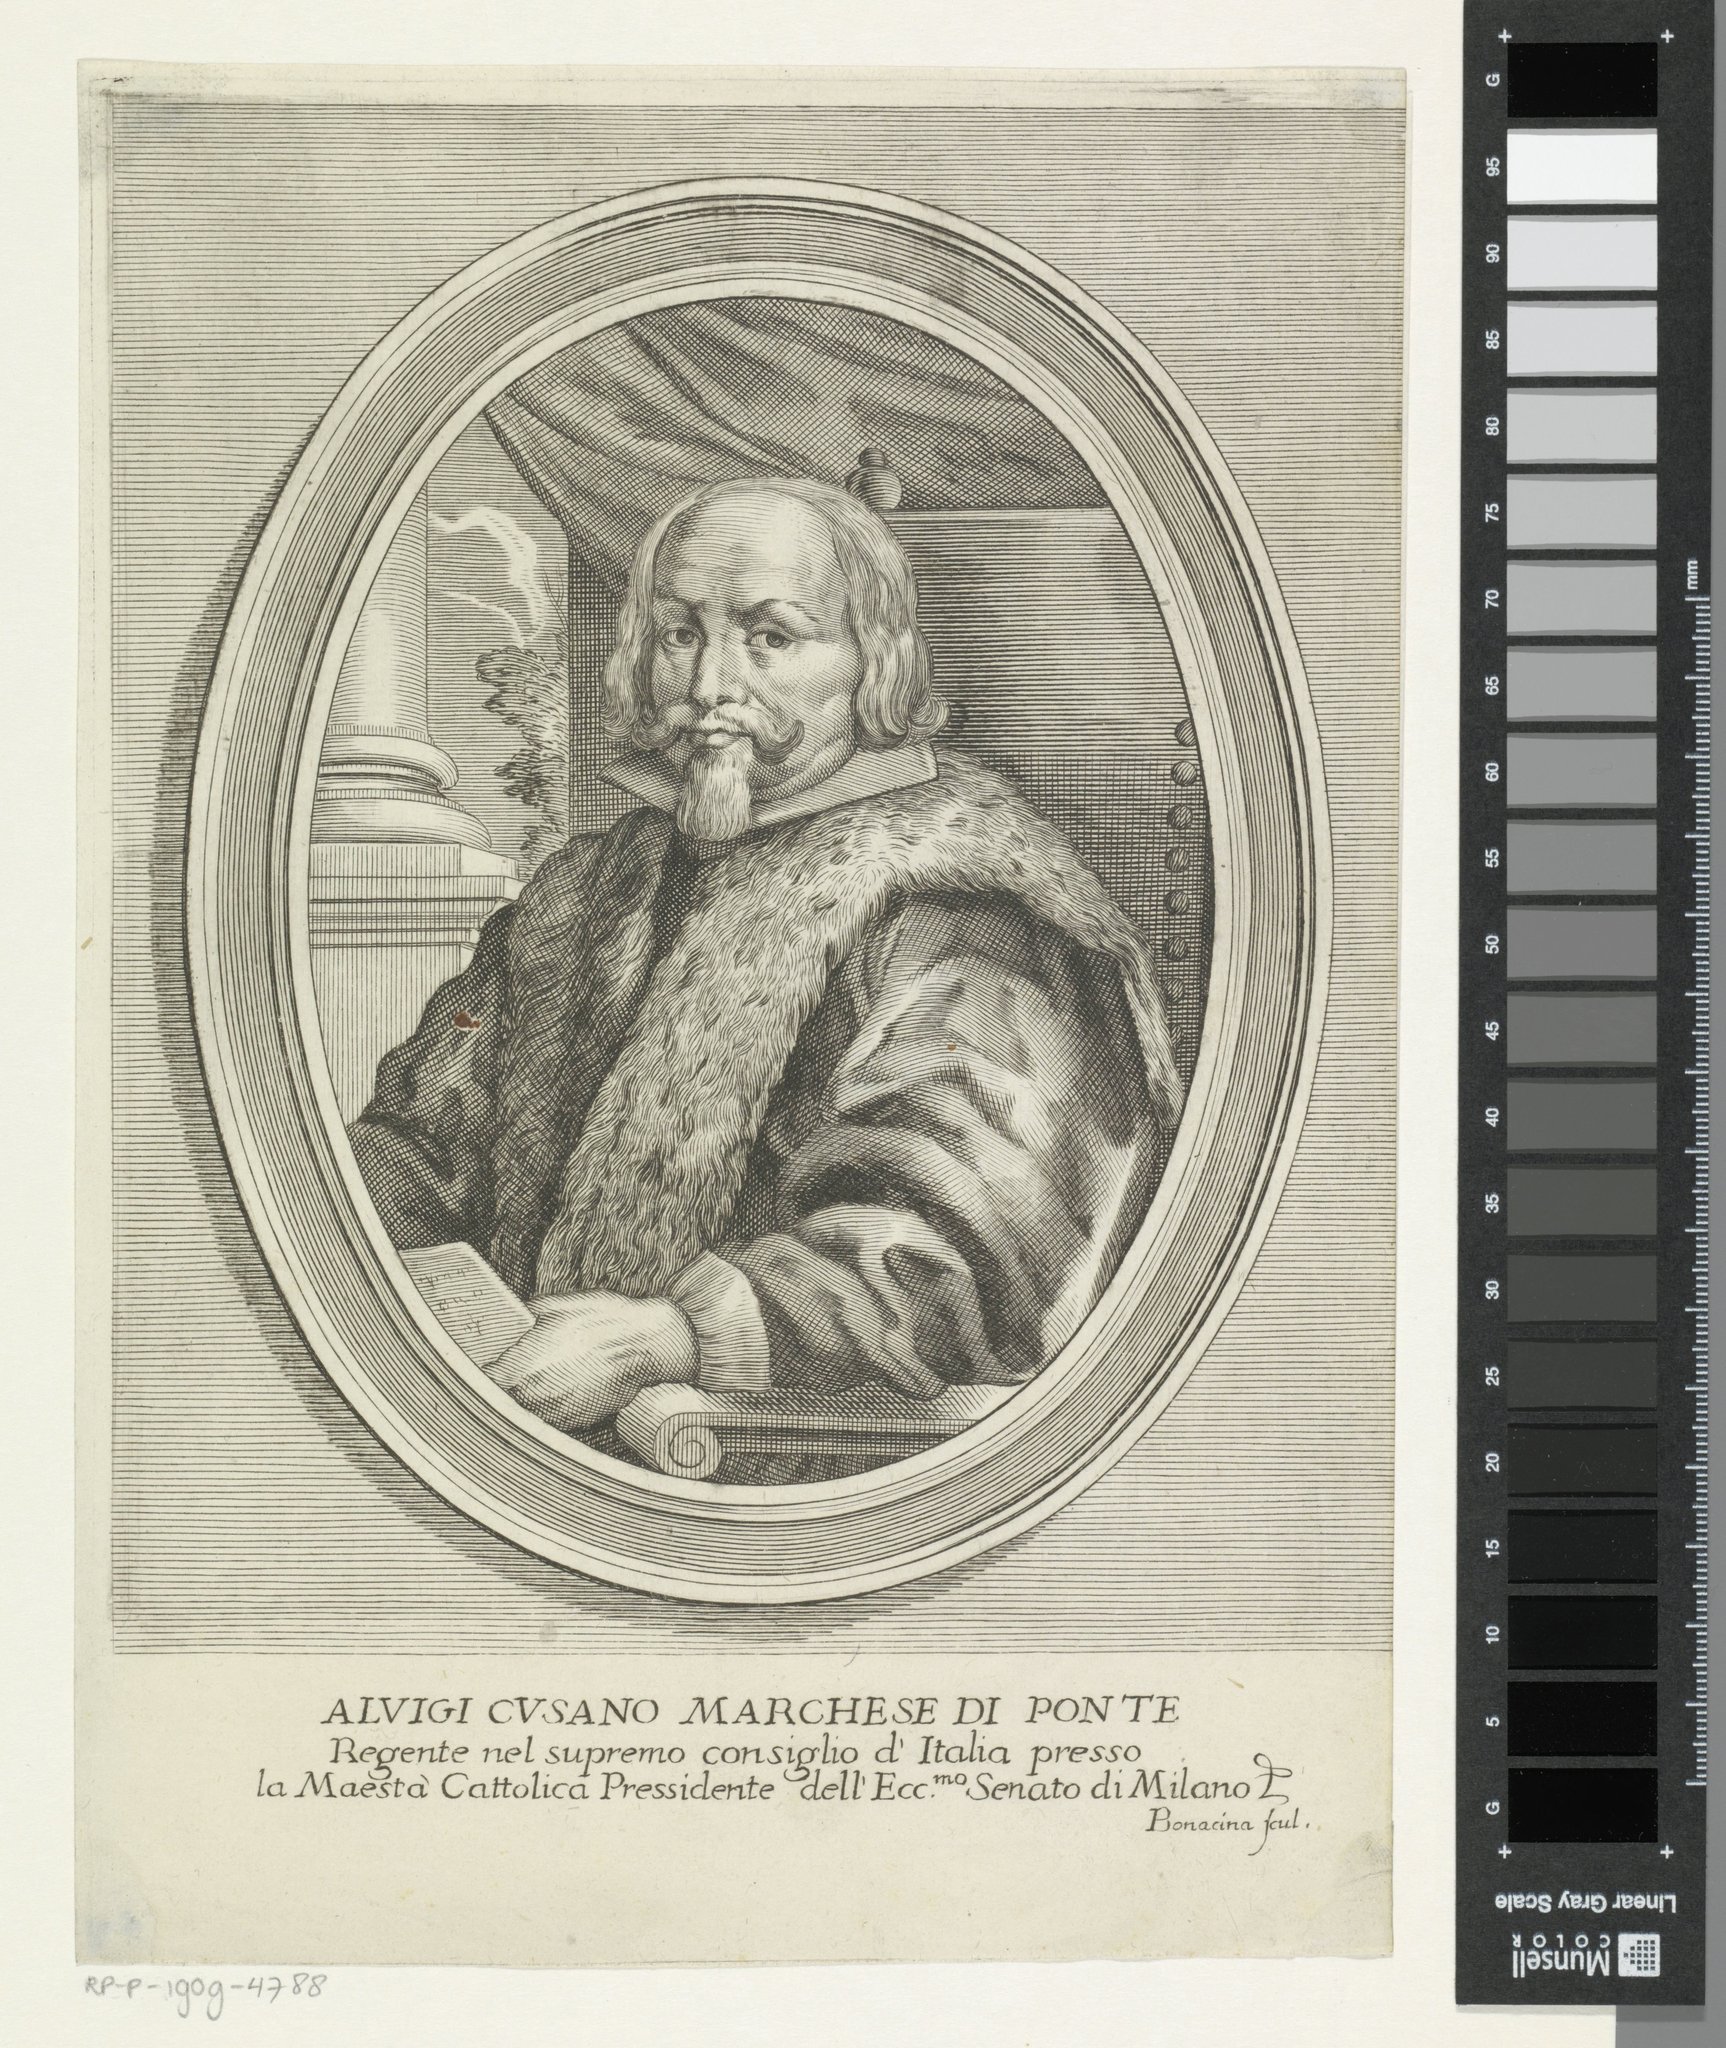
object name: print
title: Portret van Aluigi Gusano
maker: giovanni battista bonacina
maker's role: print maker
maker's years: 1615-1669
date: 1625-1669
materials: paper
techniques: engraving, etching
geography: italy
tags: historical persons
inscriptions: collector's mark: Lugt 2228